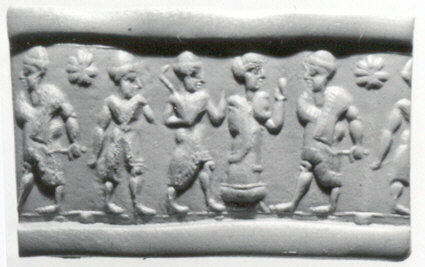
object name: cylinder seal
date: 1820-1730 BCE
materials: mineral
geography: syria